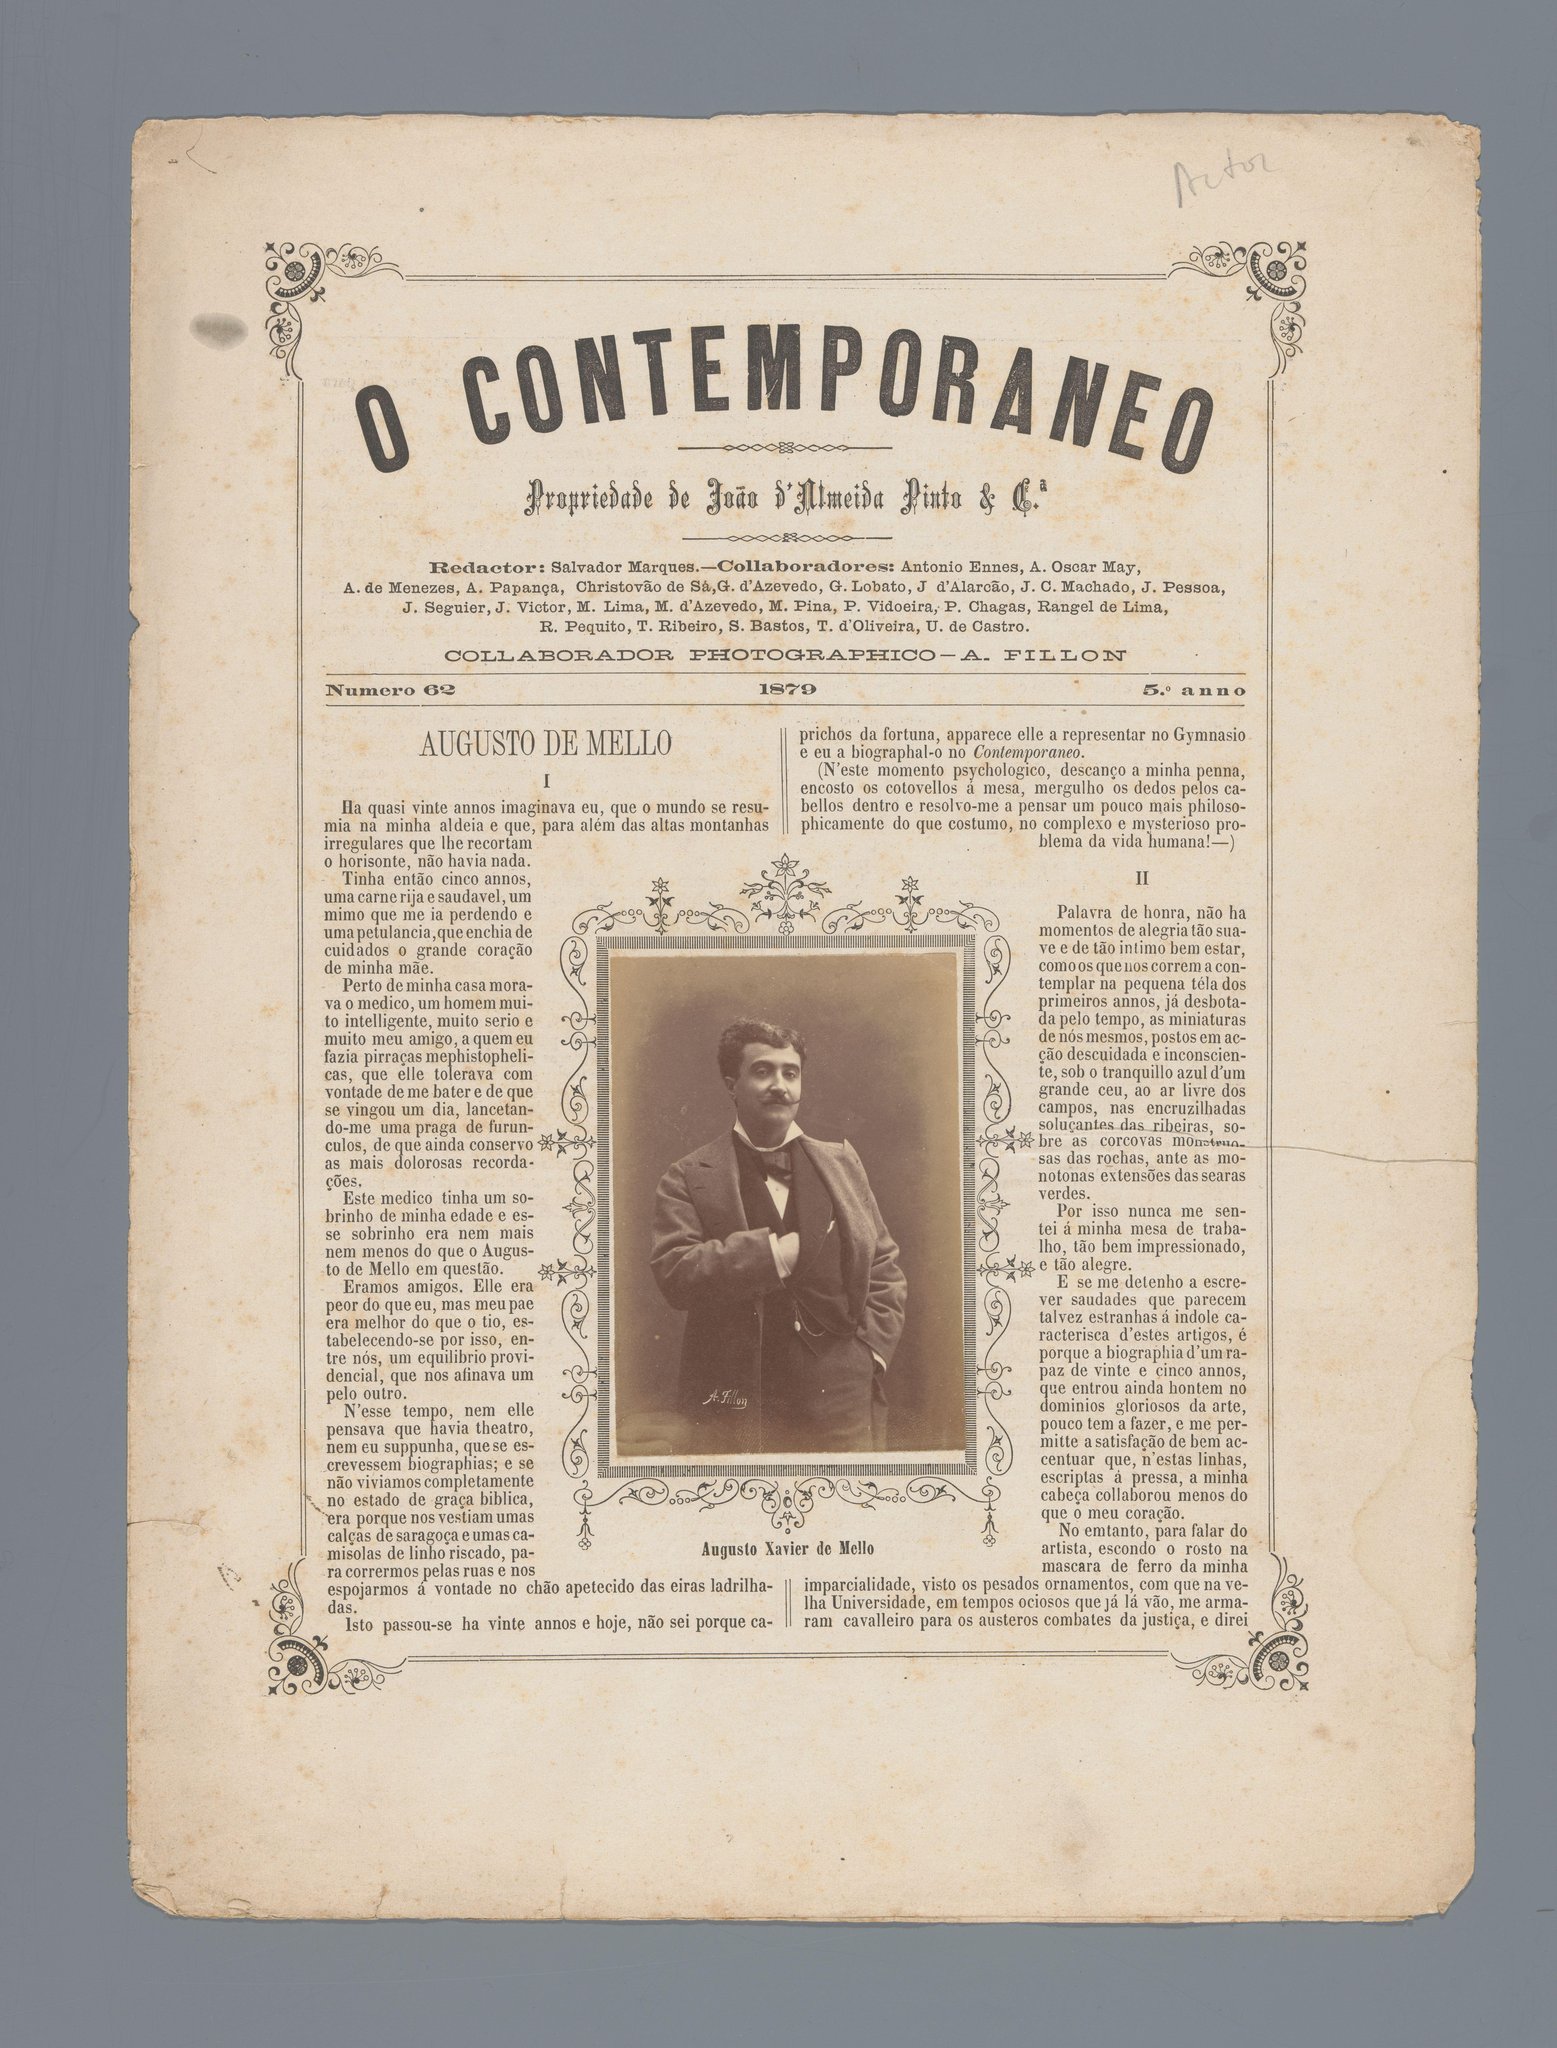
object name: photograph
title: O contemporaneo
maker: alfred fillon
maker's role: fotograaf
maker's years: 1825-1881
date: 1874-1879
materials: paper, photographic support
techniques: albumen print, printing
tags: historical persons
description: Op de voorpagina bevindt zich een portret van Augusto Xavier de Mello.